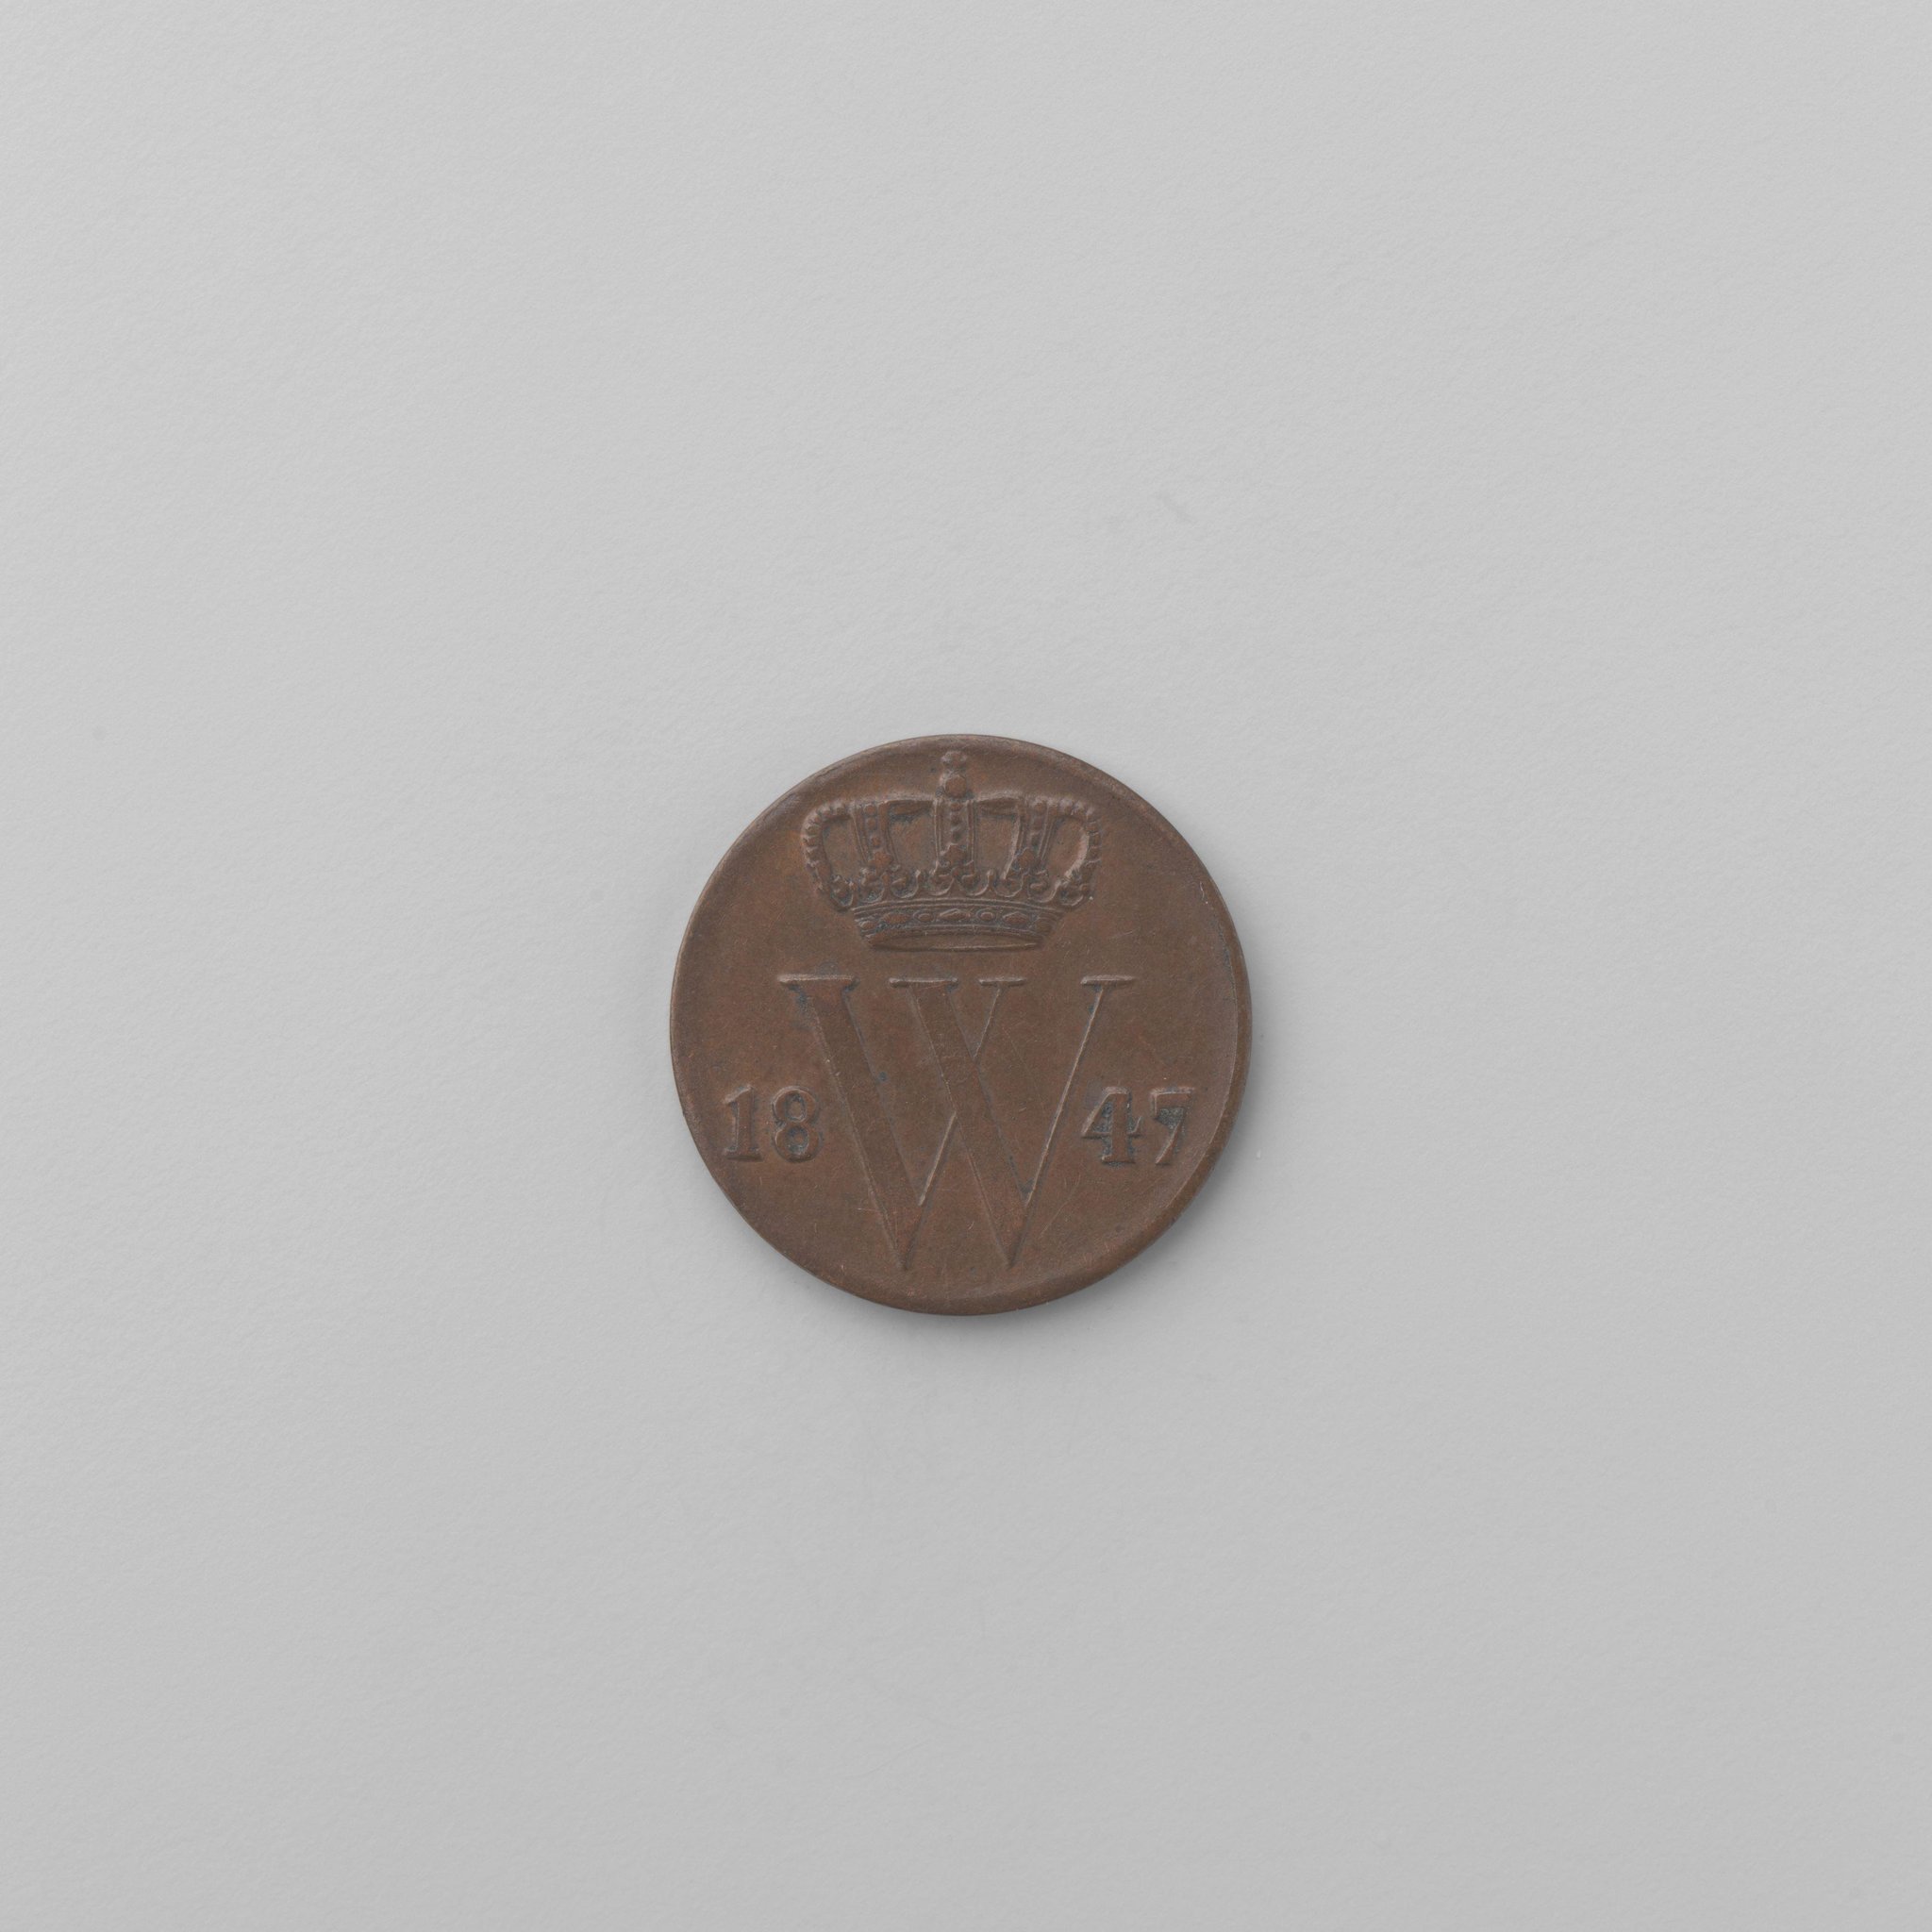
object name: coin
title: Nederlandse ½ cent, 1847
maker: william ii of the netherlands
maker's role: koning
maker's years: 1792-1849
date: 1847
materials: copper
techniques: striking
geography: utrecht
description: Koperen munt. Voorzijde: tussen jaartal gekroonde rechte letter W. Keerzijde: tussen waarde-aanduiding ½ C. gekroond rijkswapenschild. Gladde rand.